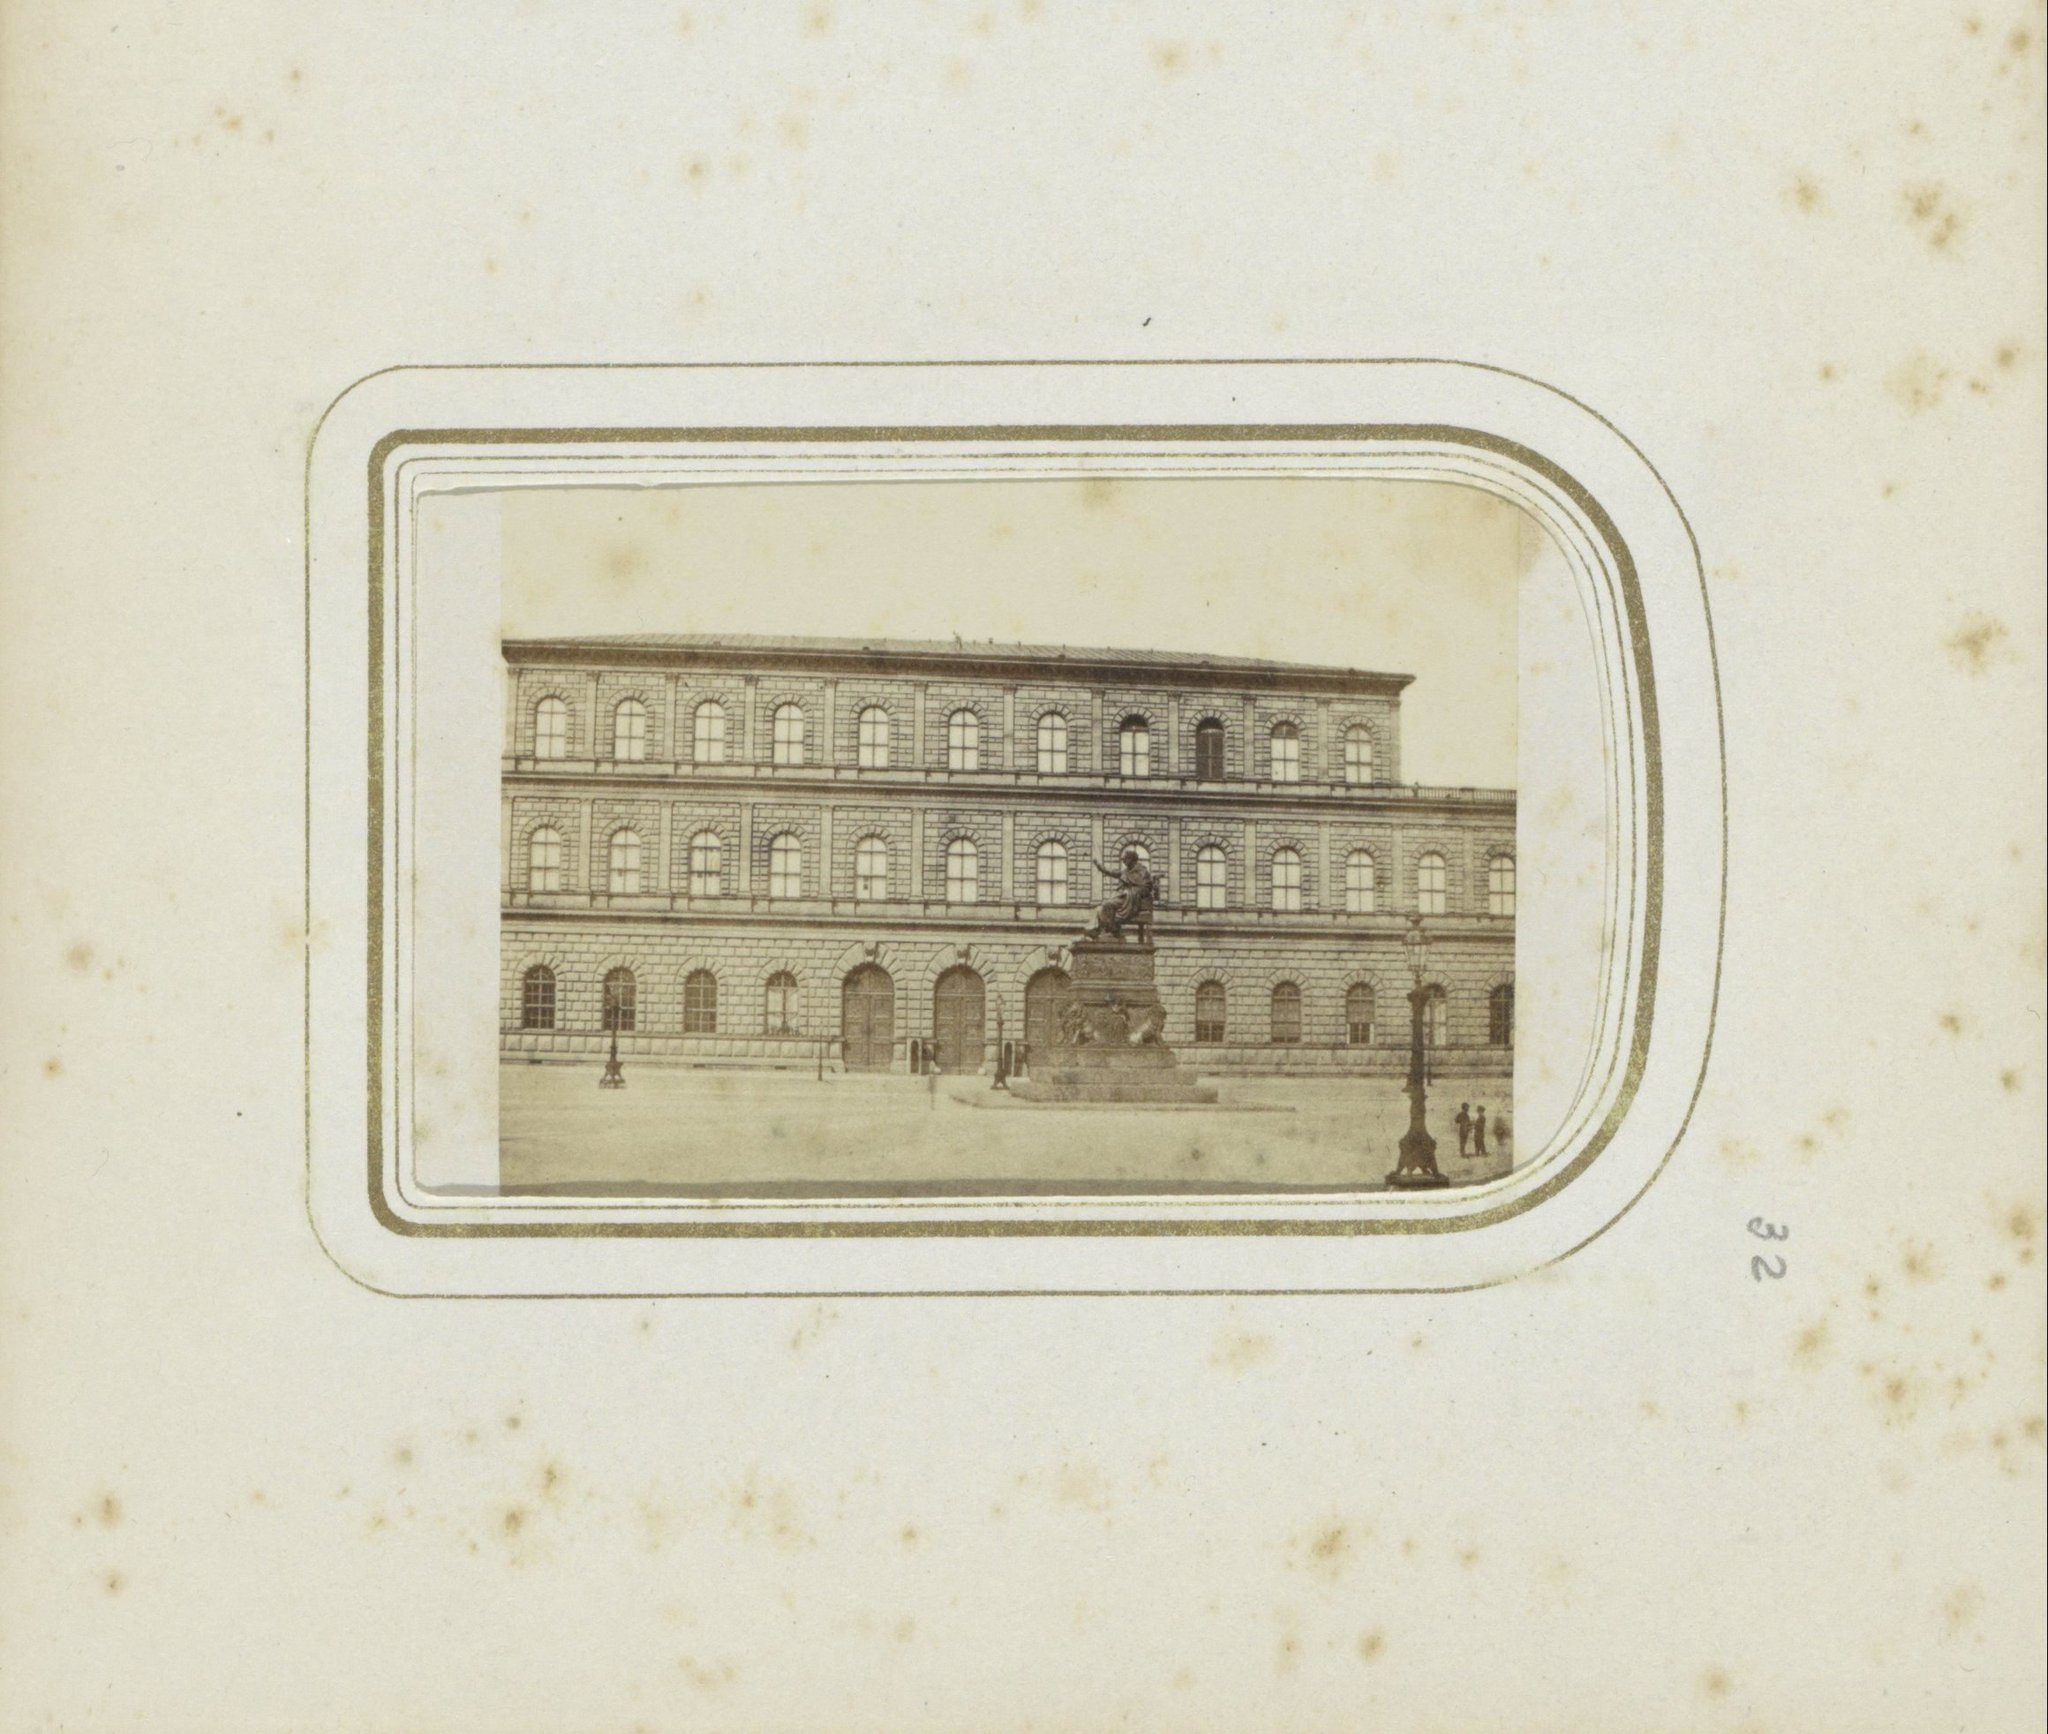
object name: photograph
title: Exterieur van de Koninklijke Residentie in München met op de voorgrond een standbeeld van Maximiliaan I Jozef van Beieren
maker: Anonymous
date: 1865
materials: paper, photographic support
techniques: albumen print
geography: munich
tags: palace, monument, statue, travelling; tourism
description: Onderdeel van Fotoalbum van een reis door Zwitserland, Oostenrijk en Duitsland door de Nederlandse familie Derkinderen.